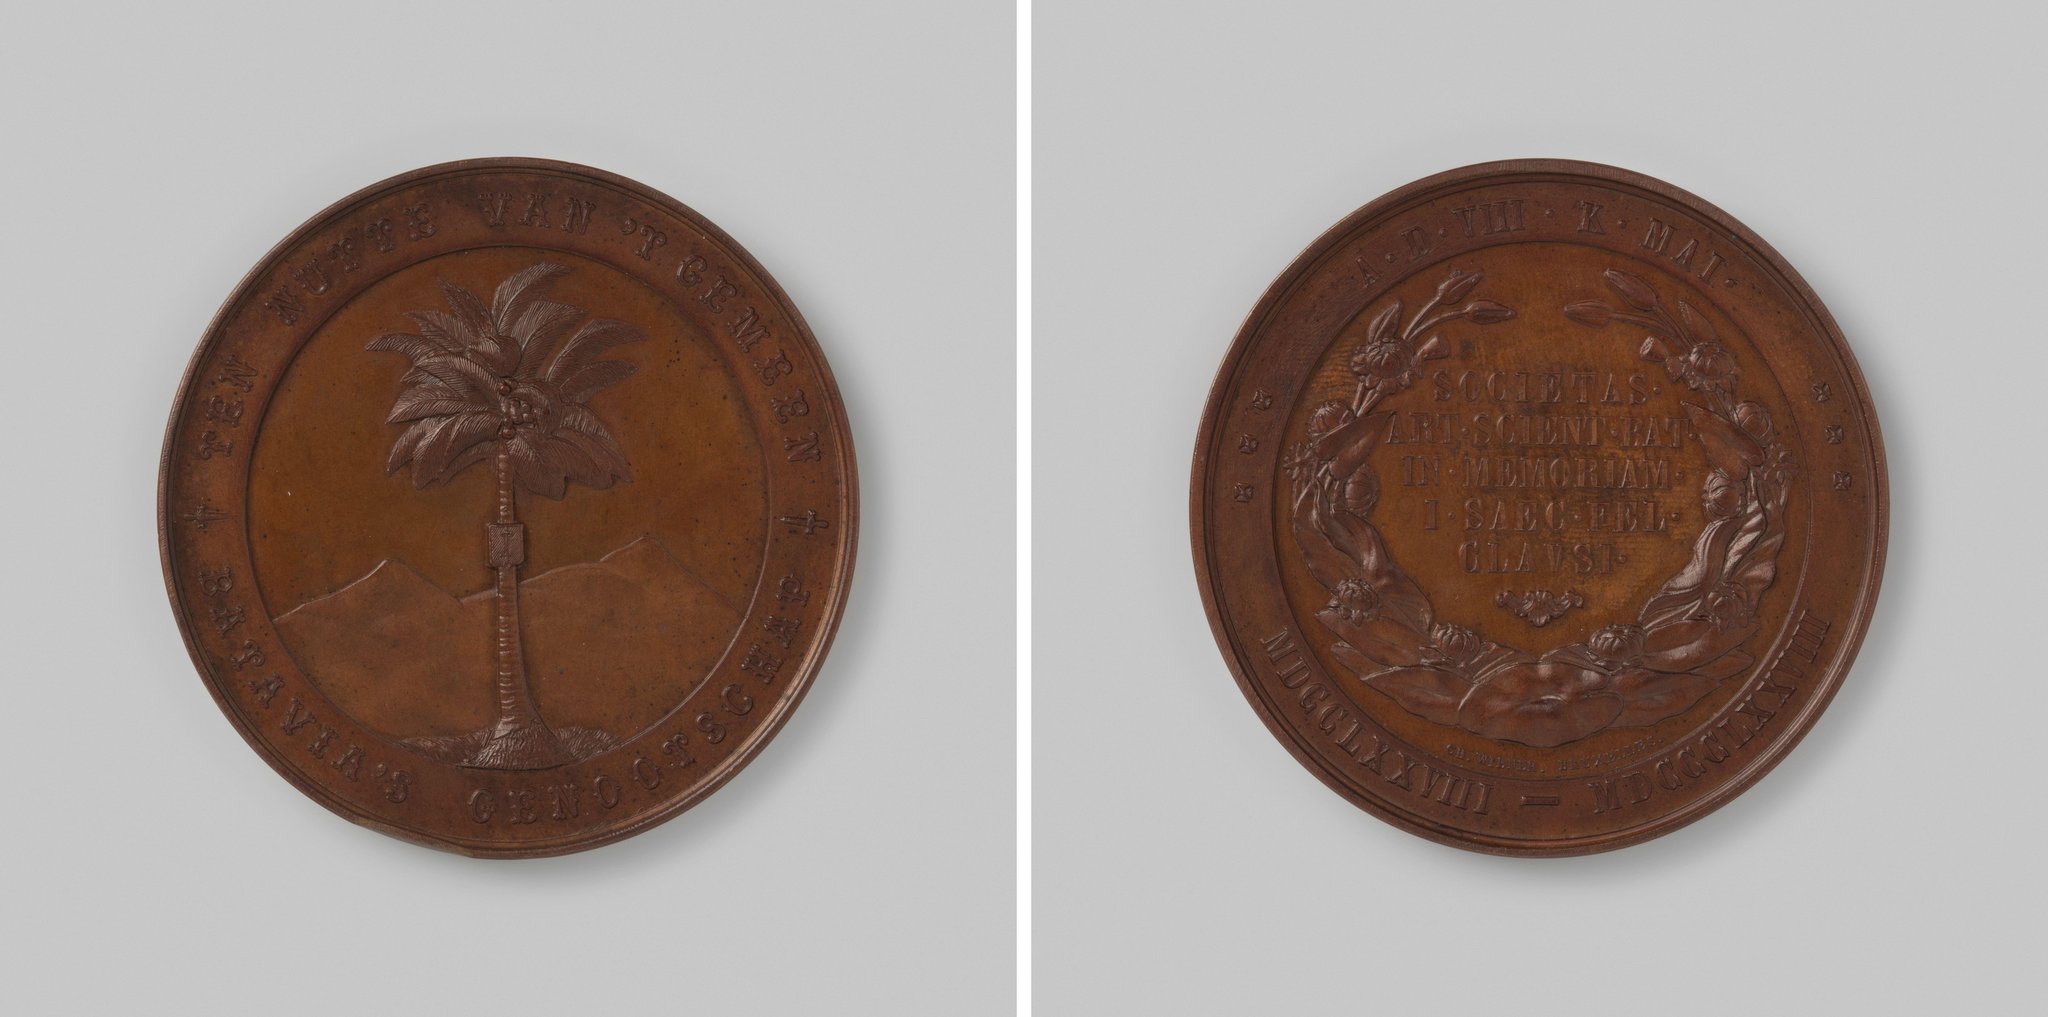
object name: medal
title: 100-jarig bestaan van het Bataviaasch Genootschap in 1878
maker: karel wiener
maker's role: medailleur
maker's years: 1831-1888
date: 1878-1889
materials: bronze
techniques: striking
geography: brussels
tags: batavia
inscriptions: inscription: ‘SOCIETAS . ART . SCIENT . BAT . IN . MEMORIAM . I . SAEC . FEL . CLAVSI .’, inscription: ‘A . D . VIII . K . MAI * * * MDCCLXXVIII - MDCCCLXxVIII’, inscription: ‘TEN NUTTE VAN 'T GEMEEN * BATAVIA'S GENOOTSCHAP’, signature and date: ‘CH . WIENER . BRUXELLES’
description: Bronzen penning. Voorzijde: Palmboom met het wapen van Batavia op de stam, met omschrift. Keerzijde: tekst in krans van waterlelies en omschrift.